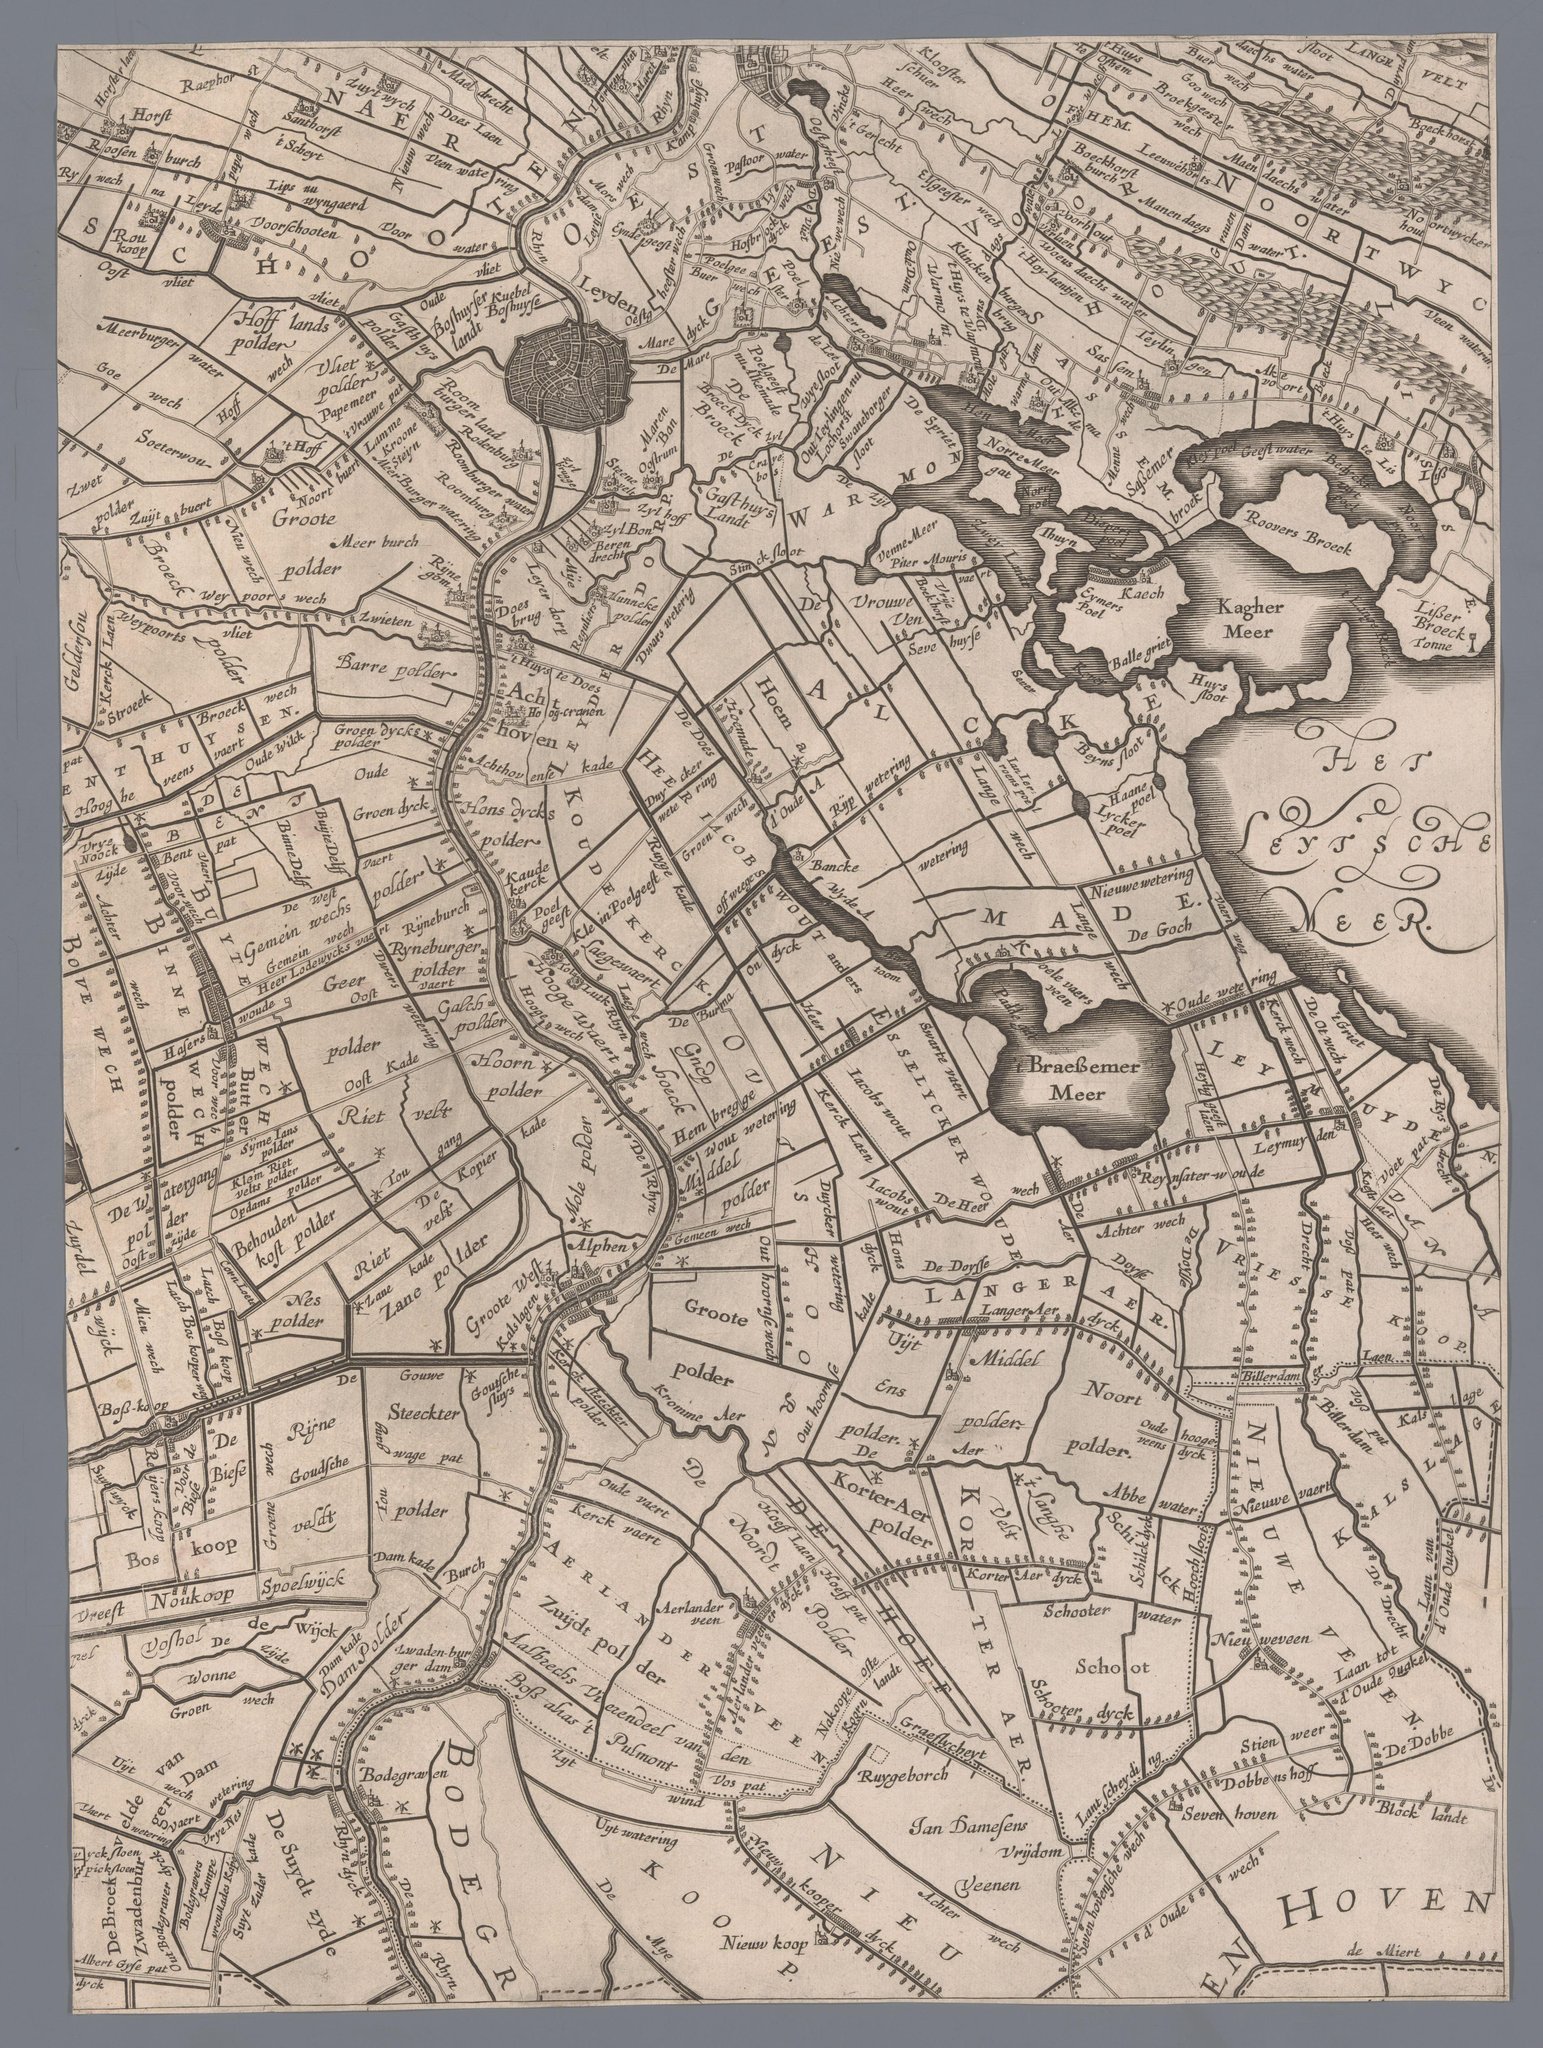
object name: map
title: Kaart van het Graafschap Holland en Utrecht (plaat 14)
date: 1639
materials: paper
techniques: engraving, etching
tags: maps, atlases, leiden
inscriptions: collector's mark: Lugt 2228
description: Onderdeel van een kaart samengesteld uit 40 bladen. Waarschijnlijk gaat het om de grootste kaart van Holland uit de zeventiende-eeuw. De kaart is uitgegeven in verschillende edities, deze kaart uit 1639 is de eerste editie.